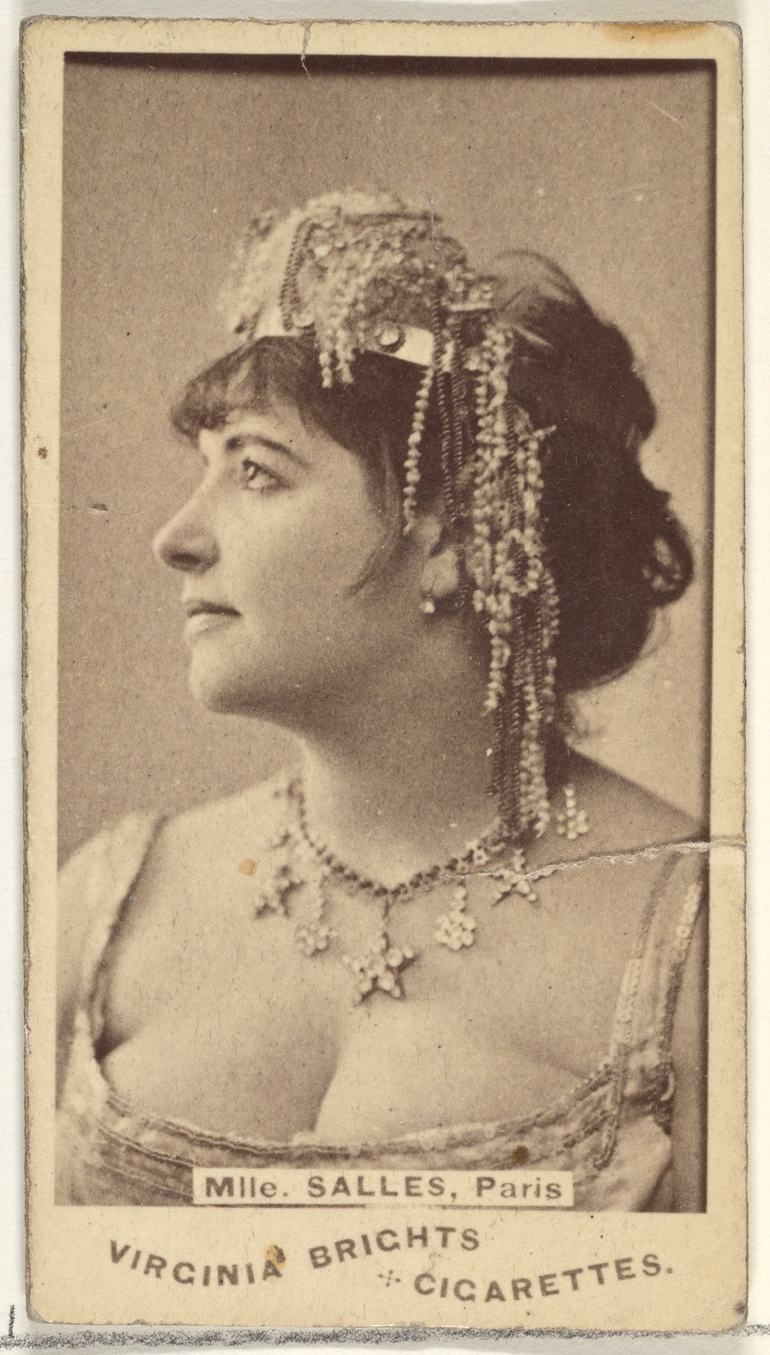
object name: photograph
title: Mlle. Salles, Paris, from the Actors and Actresses series (N45, Type 1) for Virginia Brights Cigarettes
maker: allen & ginter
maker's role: publisher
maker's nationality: american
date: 1888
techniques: albumen silver print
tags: women,actresses